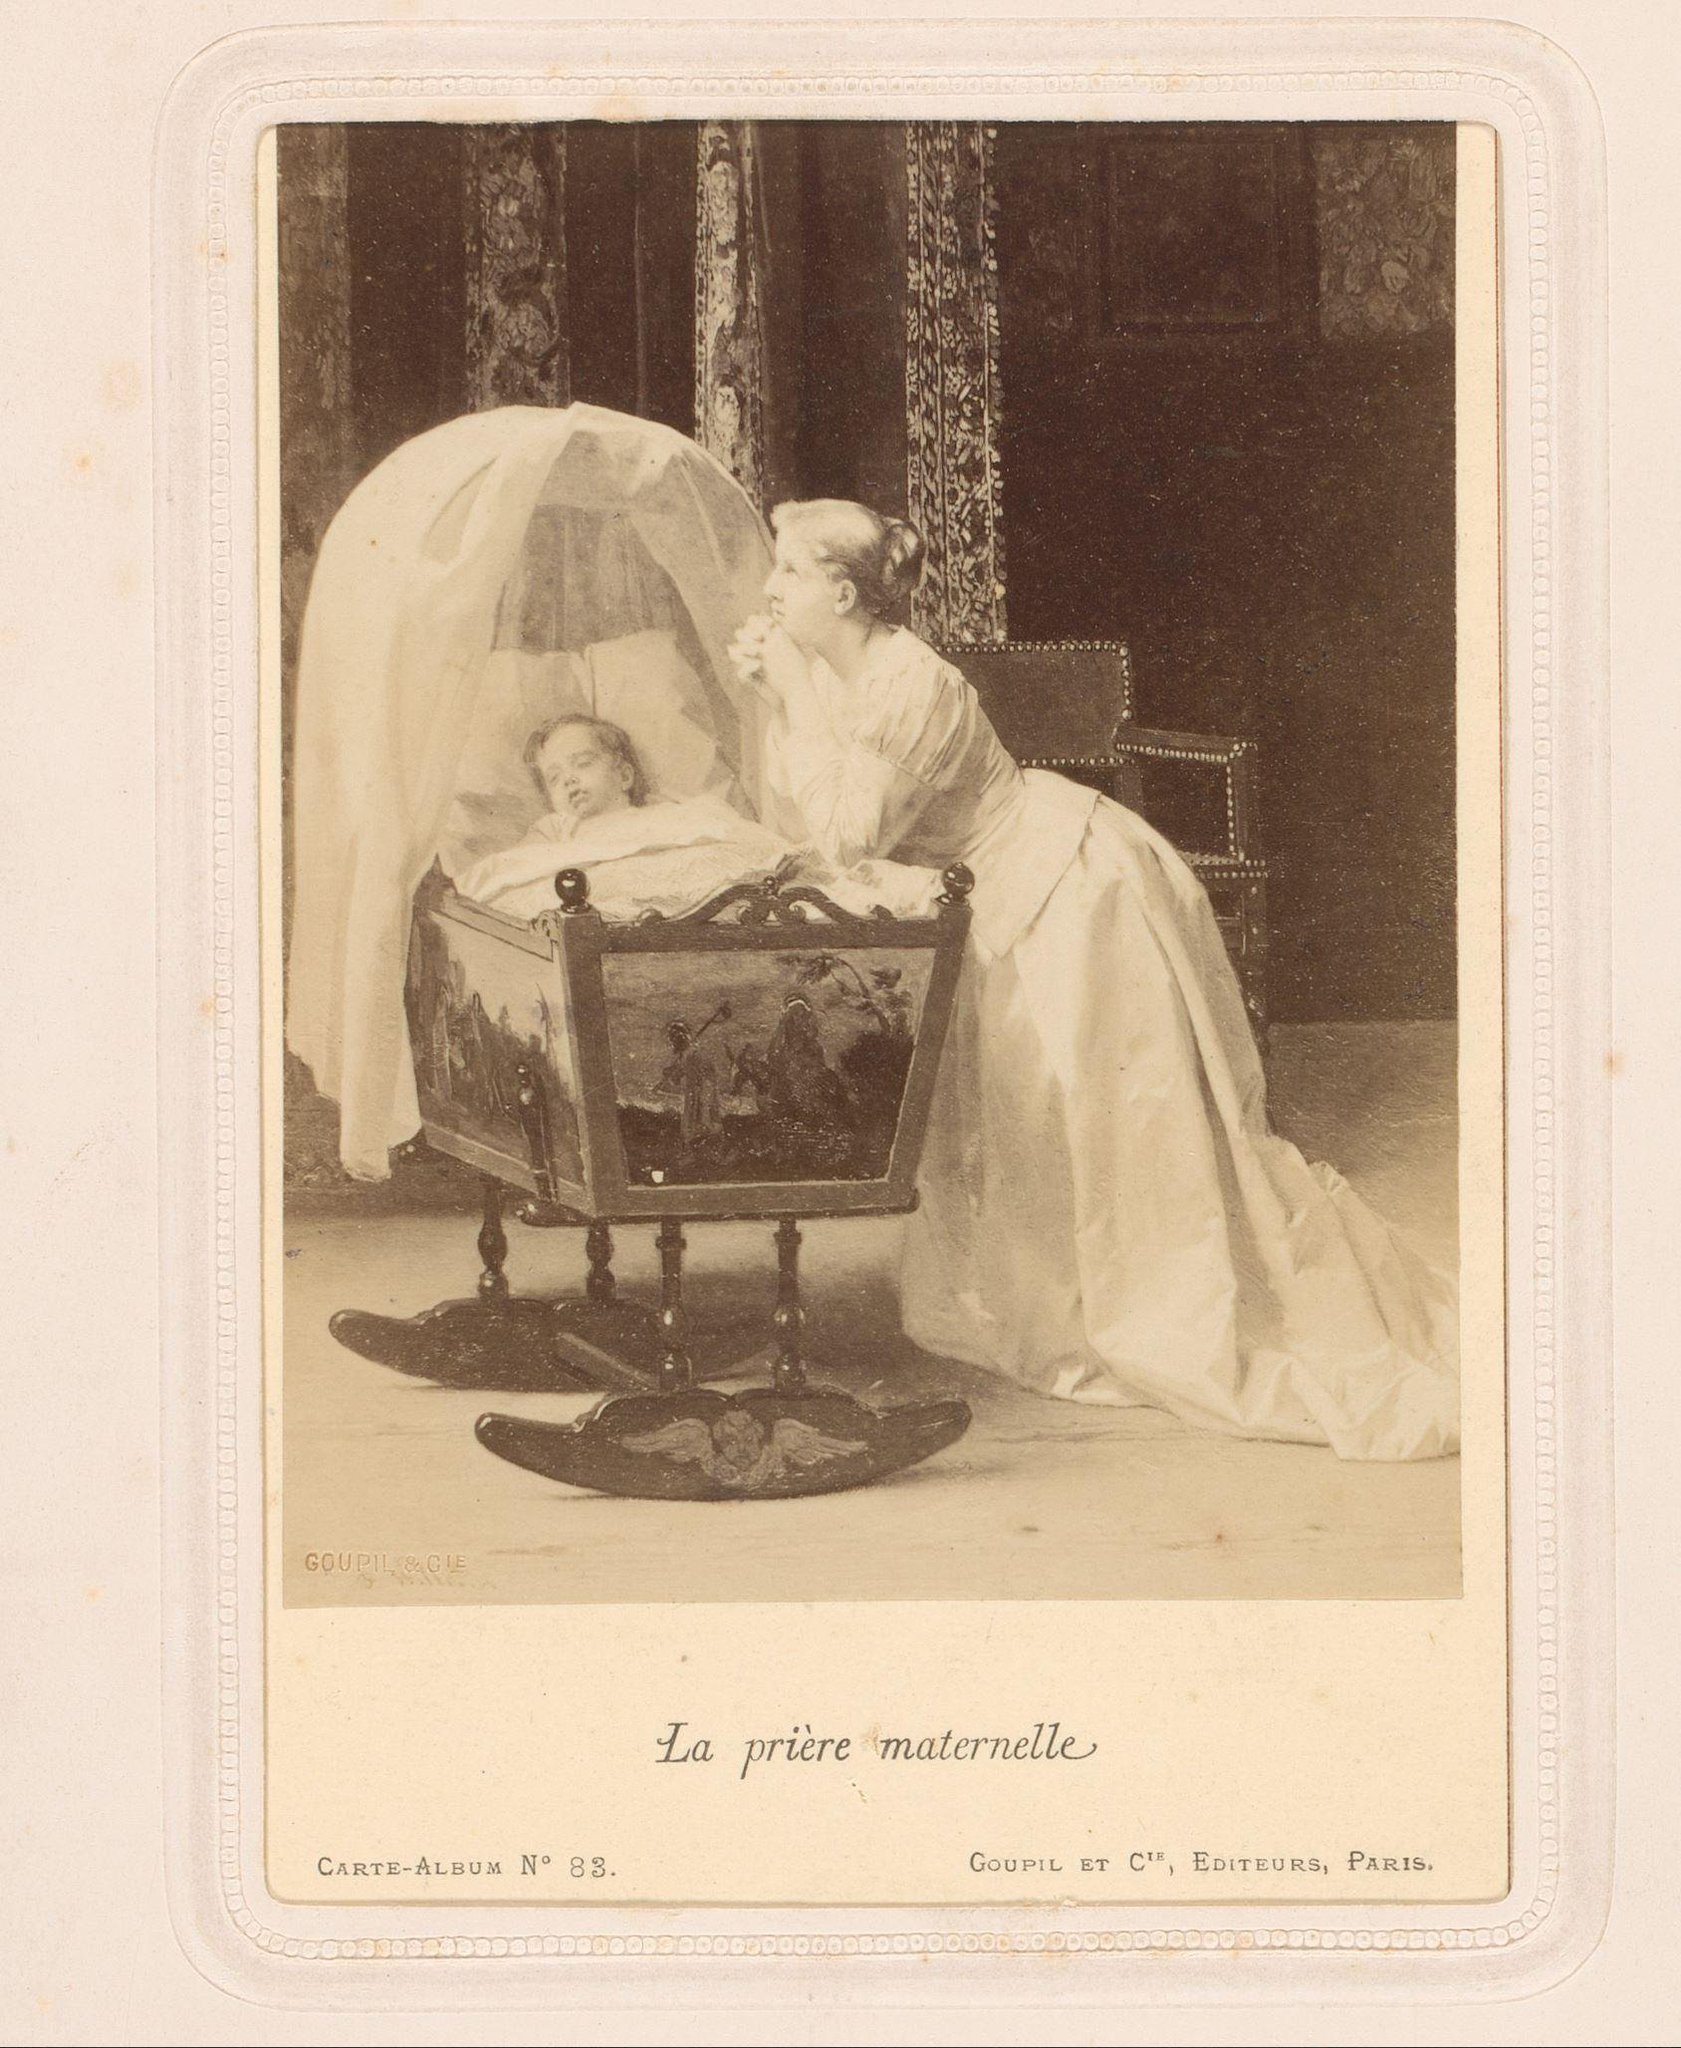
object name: reproduction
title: La priere maternelle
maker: florent willems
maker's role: painter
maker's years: 1823-1905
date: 1860-1890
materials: cardboard, photographic support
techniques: albumen print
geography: paris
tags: cradle, crib, mother-love, one person praying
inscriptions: inscription: ‘Carte-Album No 83.’